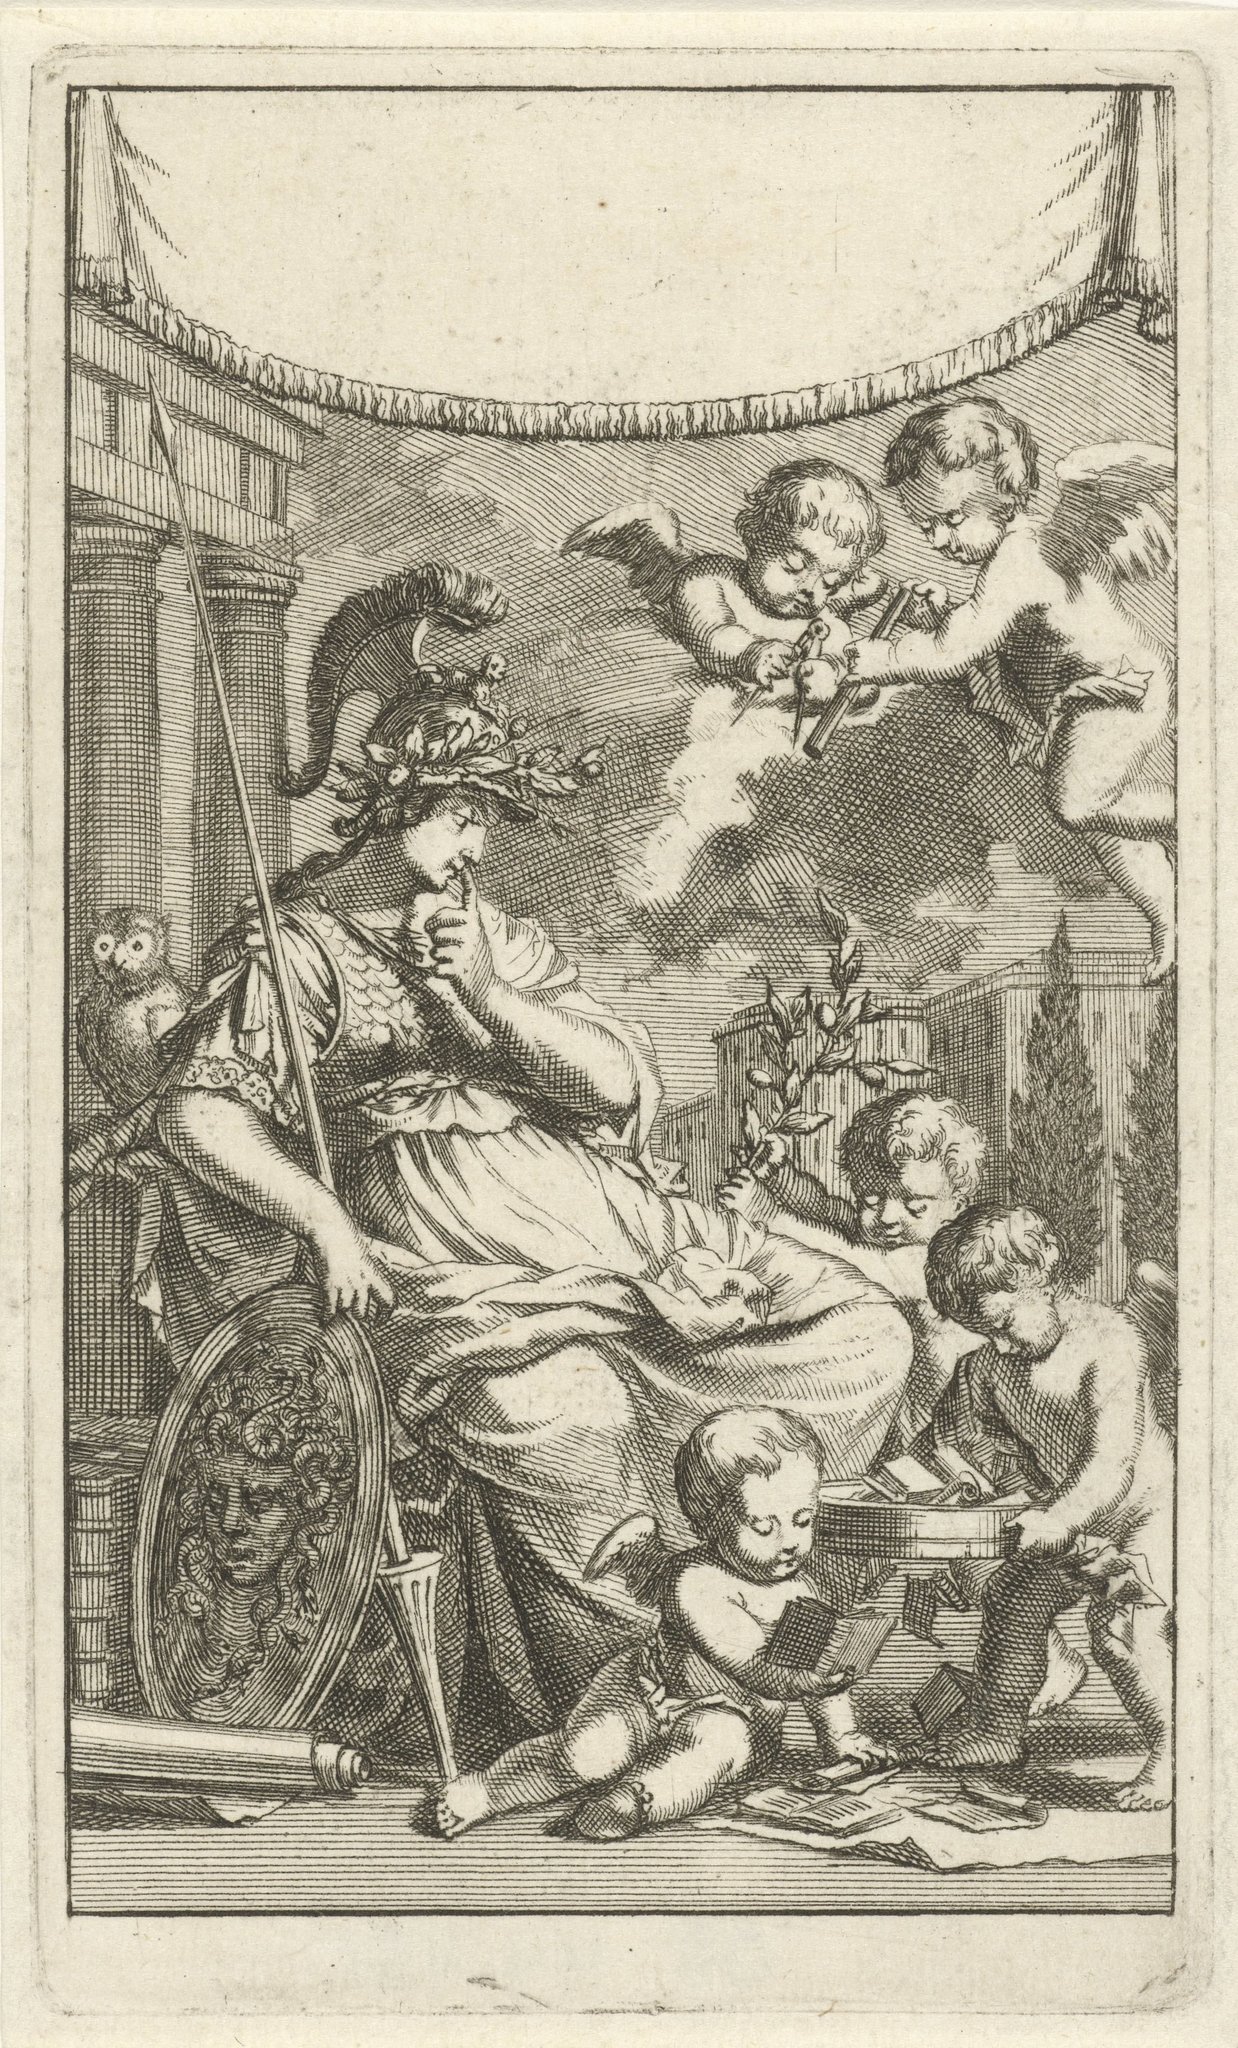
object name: print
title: Minerva omringd door engelen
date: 1693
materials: paper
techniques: etching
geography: amsterdam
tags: (story of) minerva (pallas, athena), angels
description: Proefdruk titelpagina voor: Sánchez de las Brozas, Francisco. Minerva, sive De causis Latinae linguae commentarius. Franeker: Leonardus Strick, 1693.